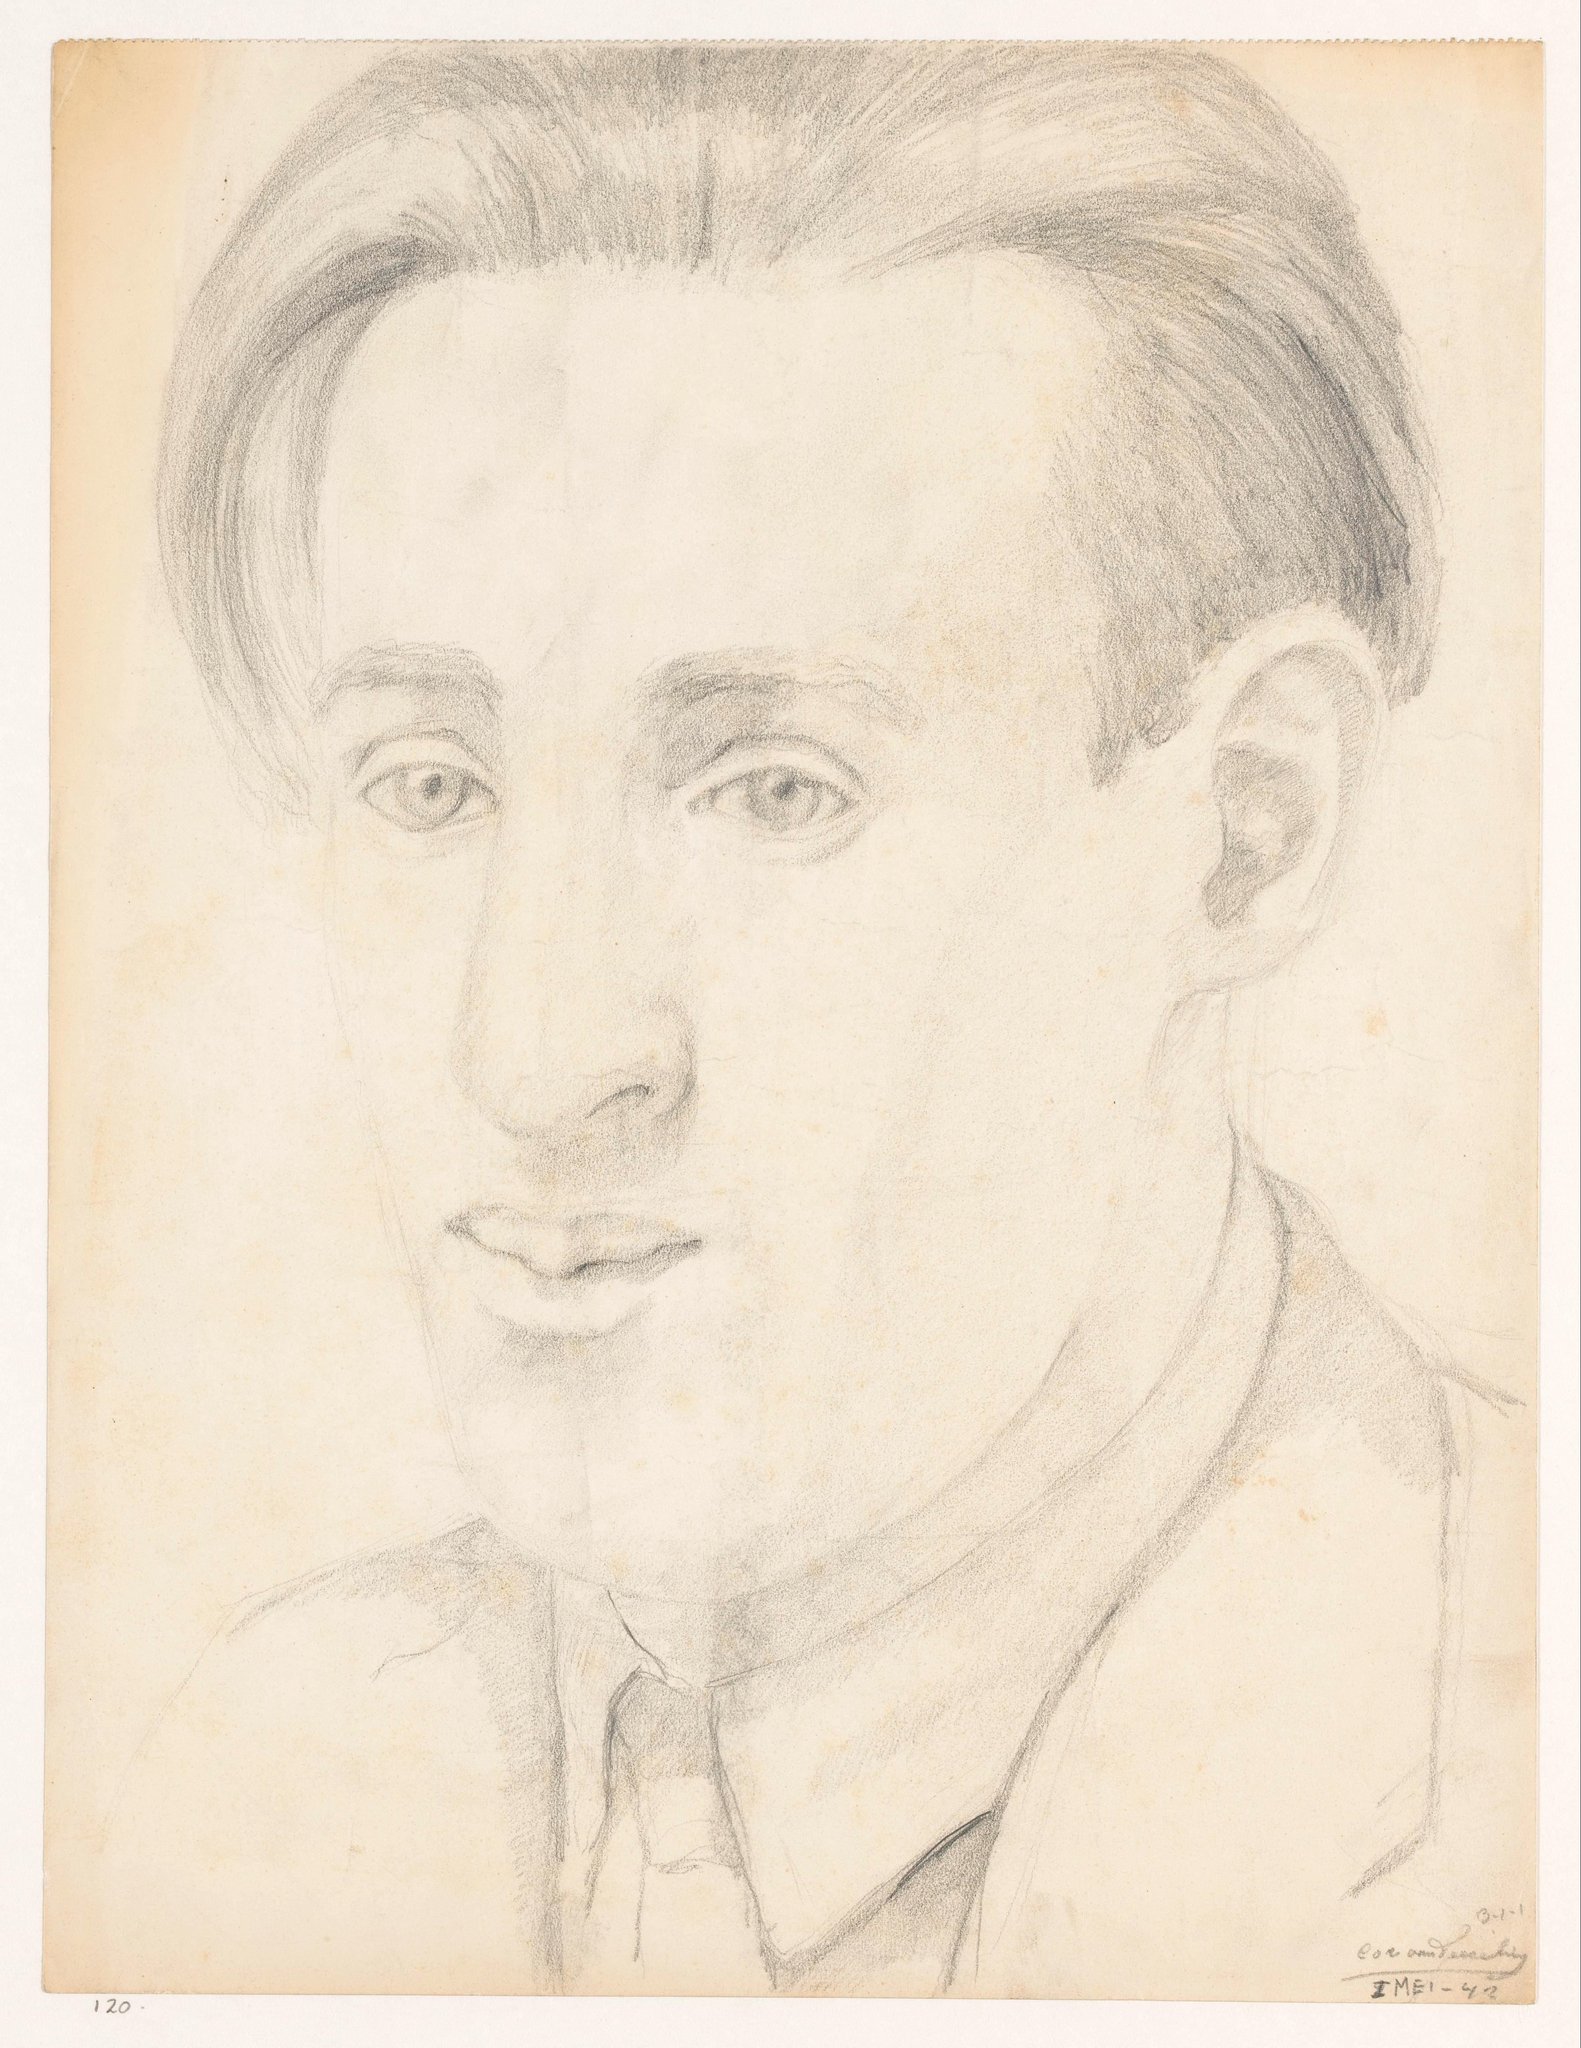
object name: drawing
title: Zelfportretten van Cor van Teeseling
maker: cor van teeseling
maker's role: draughtsman, sculptor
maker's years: 1915-1942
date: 1942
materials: paper, pencil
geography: weteringschans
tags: amsterdam, draughtsman, sculptor, cor van teeseling, historical persons, prisoner in cell or locked place, portrait, self-portrait of draughtsman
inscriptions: signature and date: ‘B-1-1 / Cor van Teeseling / I mei-42’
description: Zelfportret van Cor van Teeseling: B-1-1, 1 mei. Cor van Teeseling driekwart afgebeeld, zijn hoofd naar links gewend.